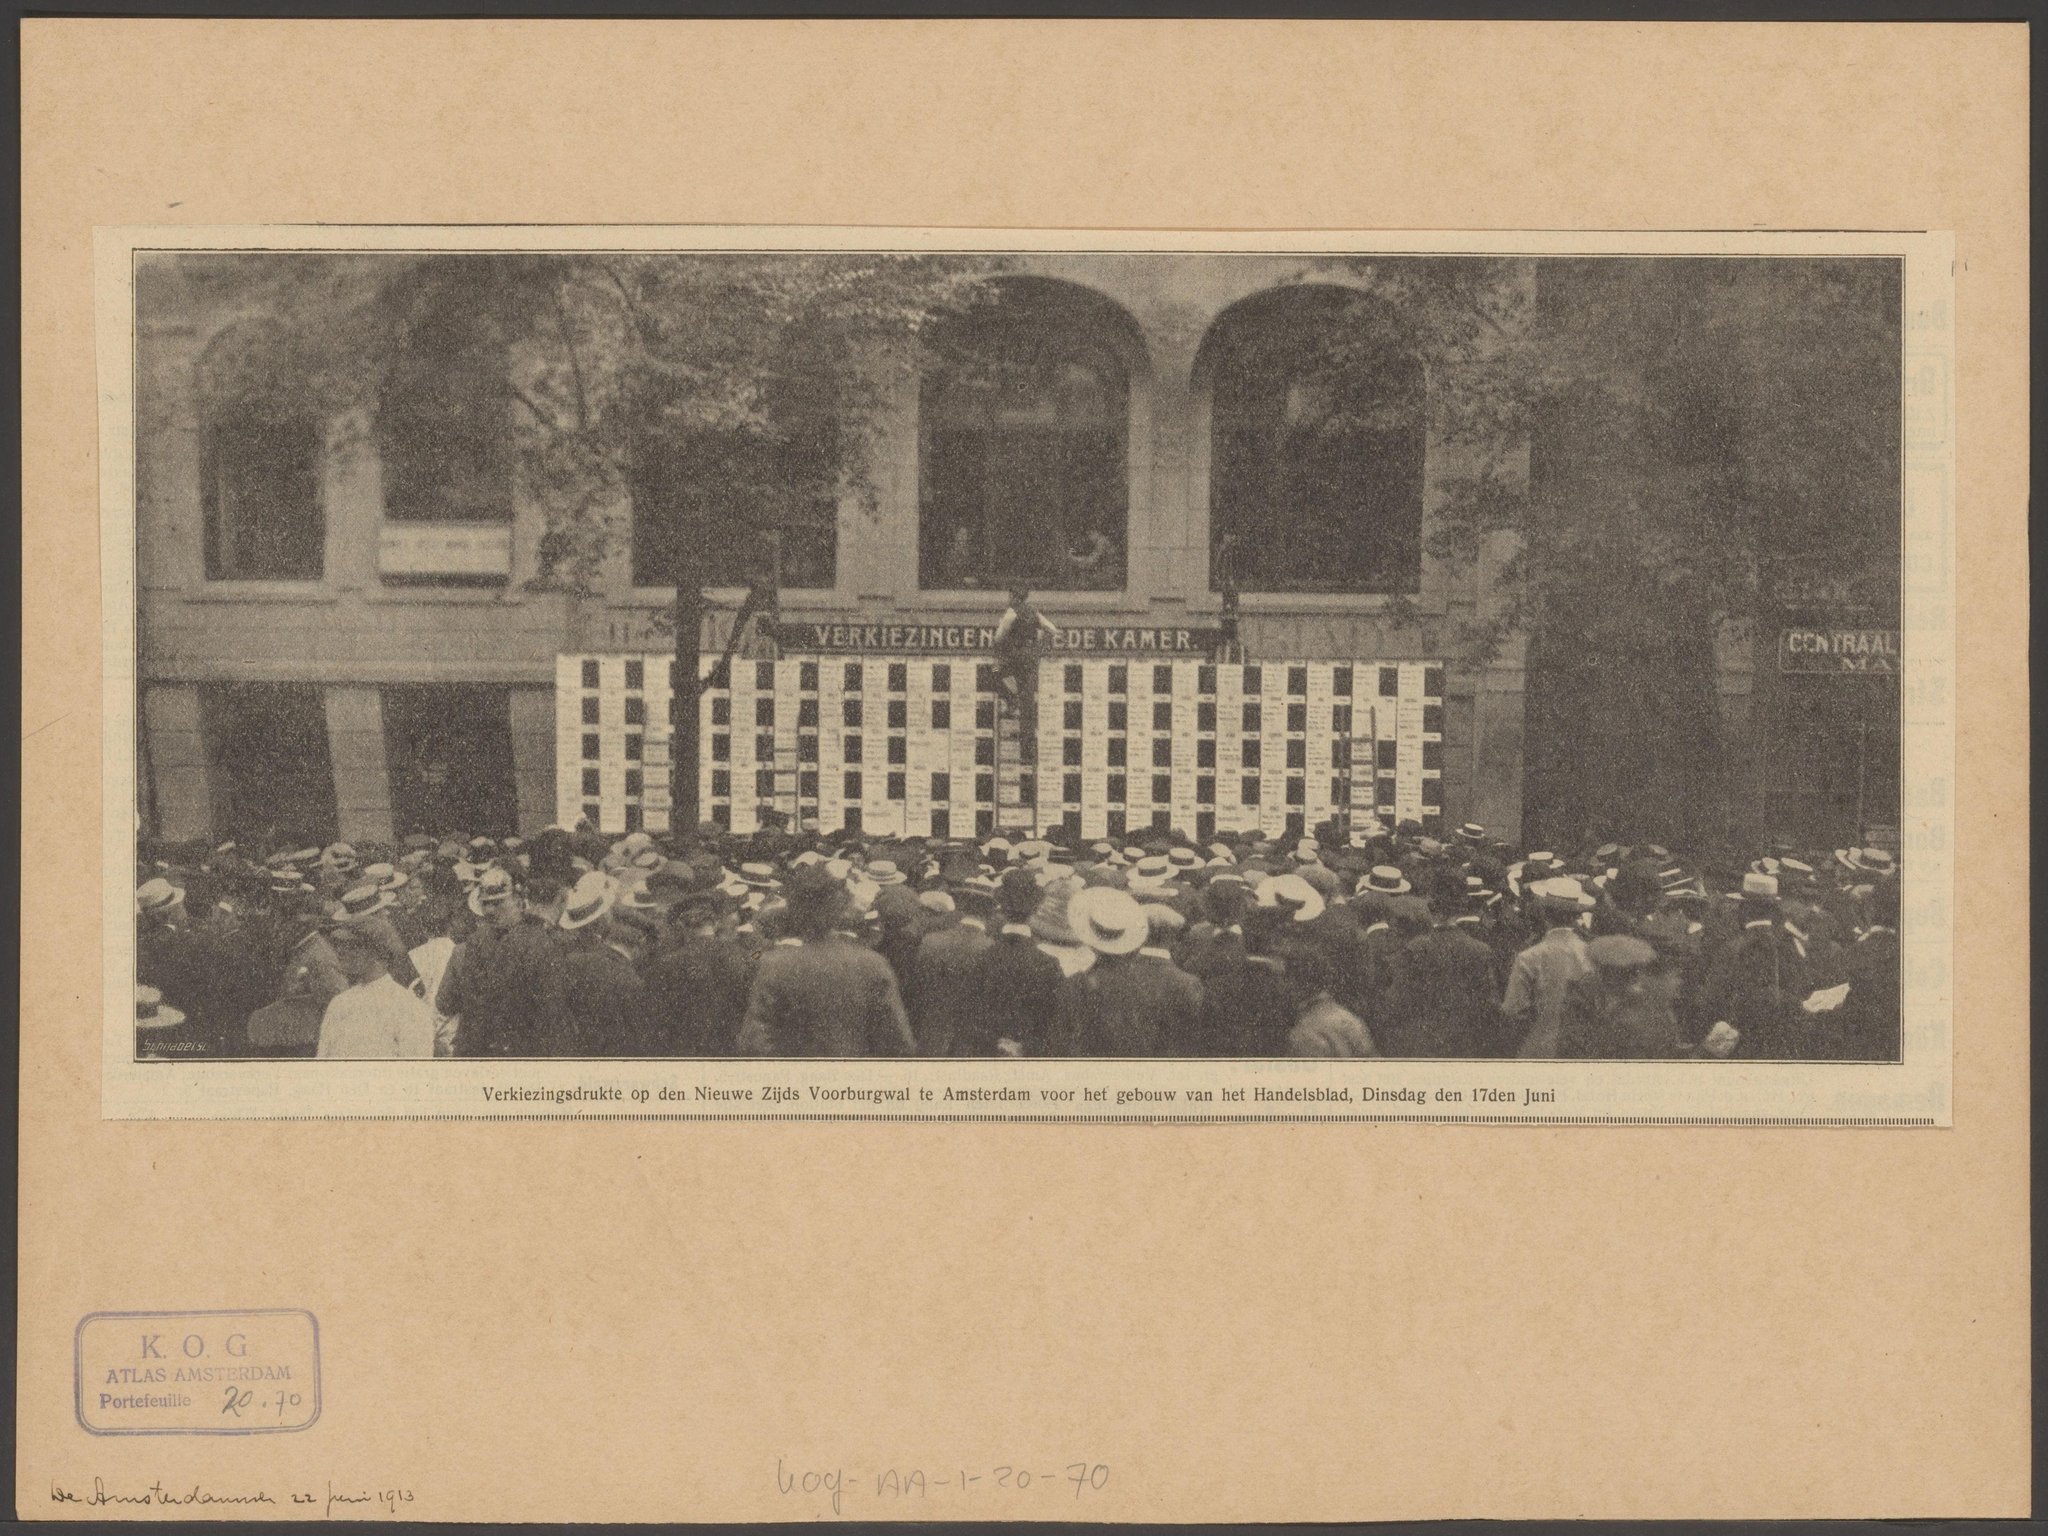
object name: photomechanical print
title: Mensenmassa voor het gebouw van het Algemeen Handelsblad tijdens de bekendmaking van de verkiezingsuitslag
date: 1913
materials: paper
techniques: letterpress printing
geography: netherlands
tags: voting, election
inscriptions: collector's mark: Lugt 1641b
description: Onderwerpsrubriek binnen de Atlas Amsterdam: Verkiezingen Tweede Kamer.